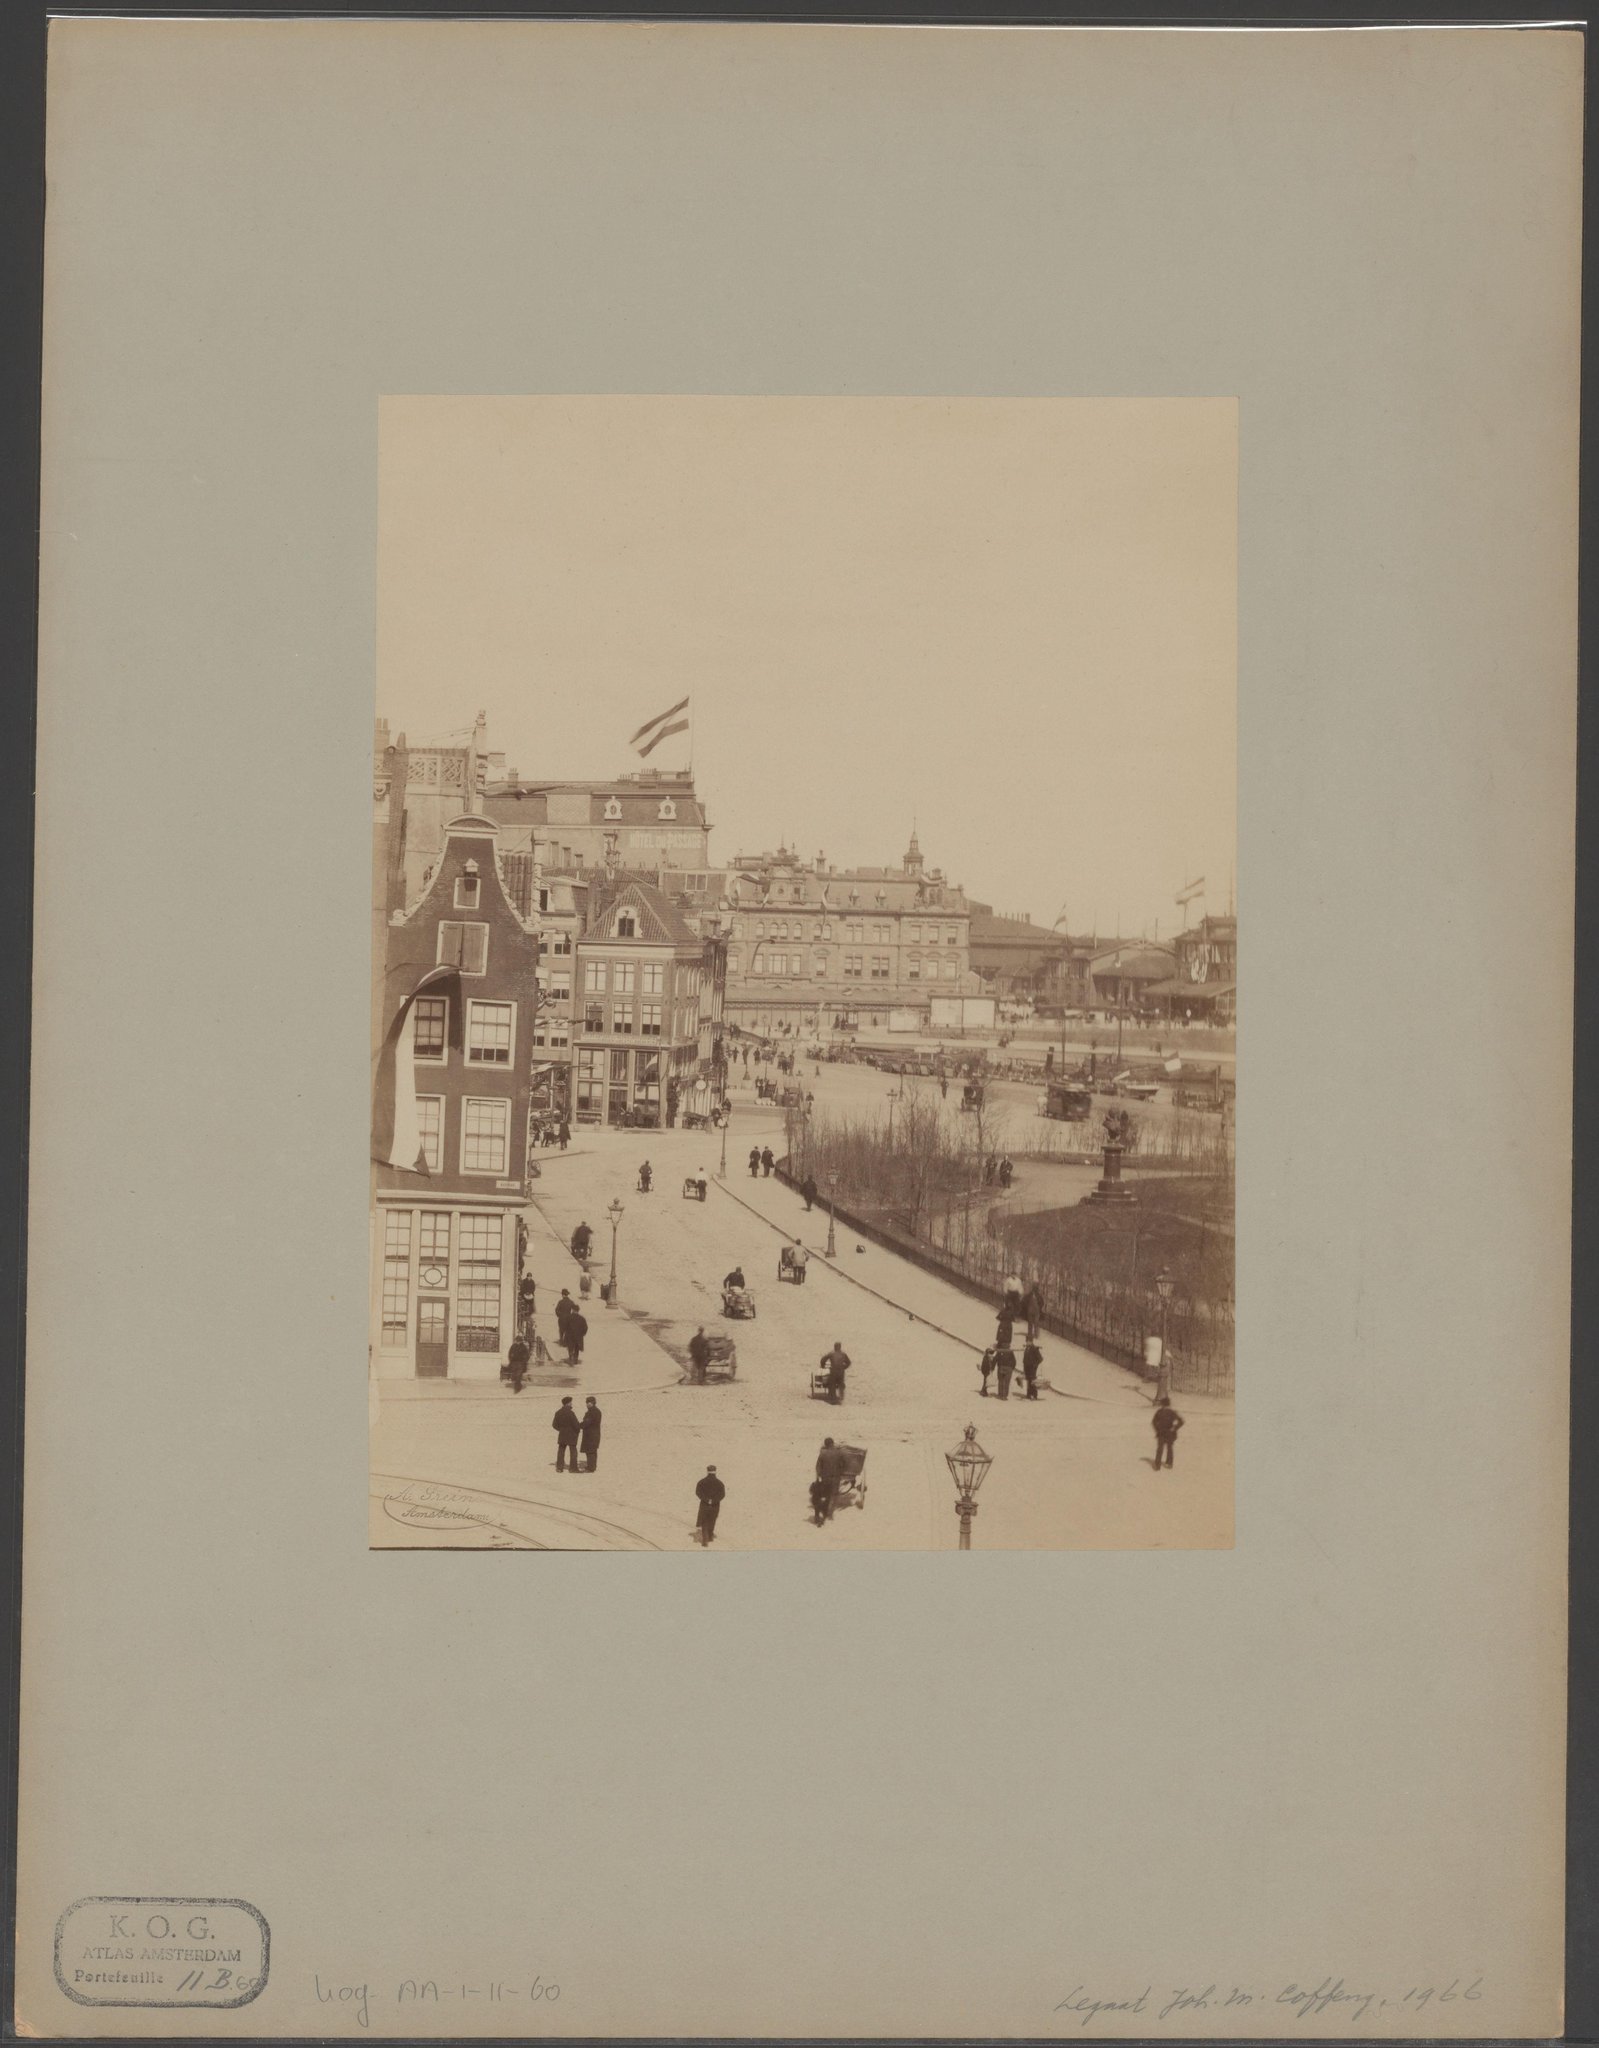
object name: photograph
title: Gezicht op de Prins Hendrikkade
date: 1861-1938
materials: cardboard, paper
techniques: albumen print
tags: city-view in general; 'veduta', street, hotel, hostelry, inn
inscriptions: inscription: ‘Legaat Joh. M. Coffeng. 1966’, collector's mark: ‘11B.60’ Lugt 1641b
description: Onderwerpsrubriek binnen de Atlas Amsterdam: Prinsengracht, Korte Prinsengracht, Prins Hendrikkade. Zie ook Portefeuille 1: gezichten van het IJ op de stad.